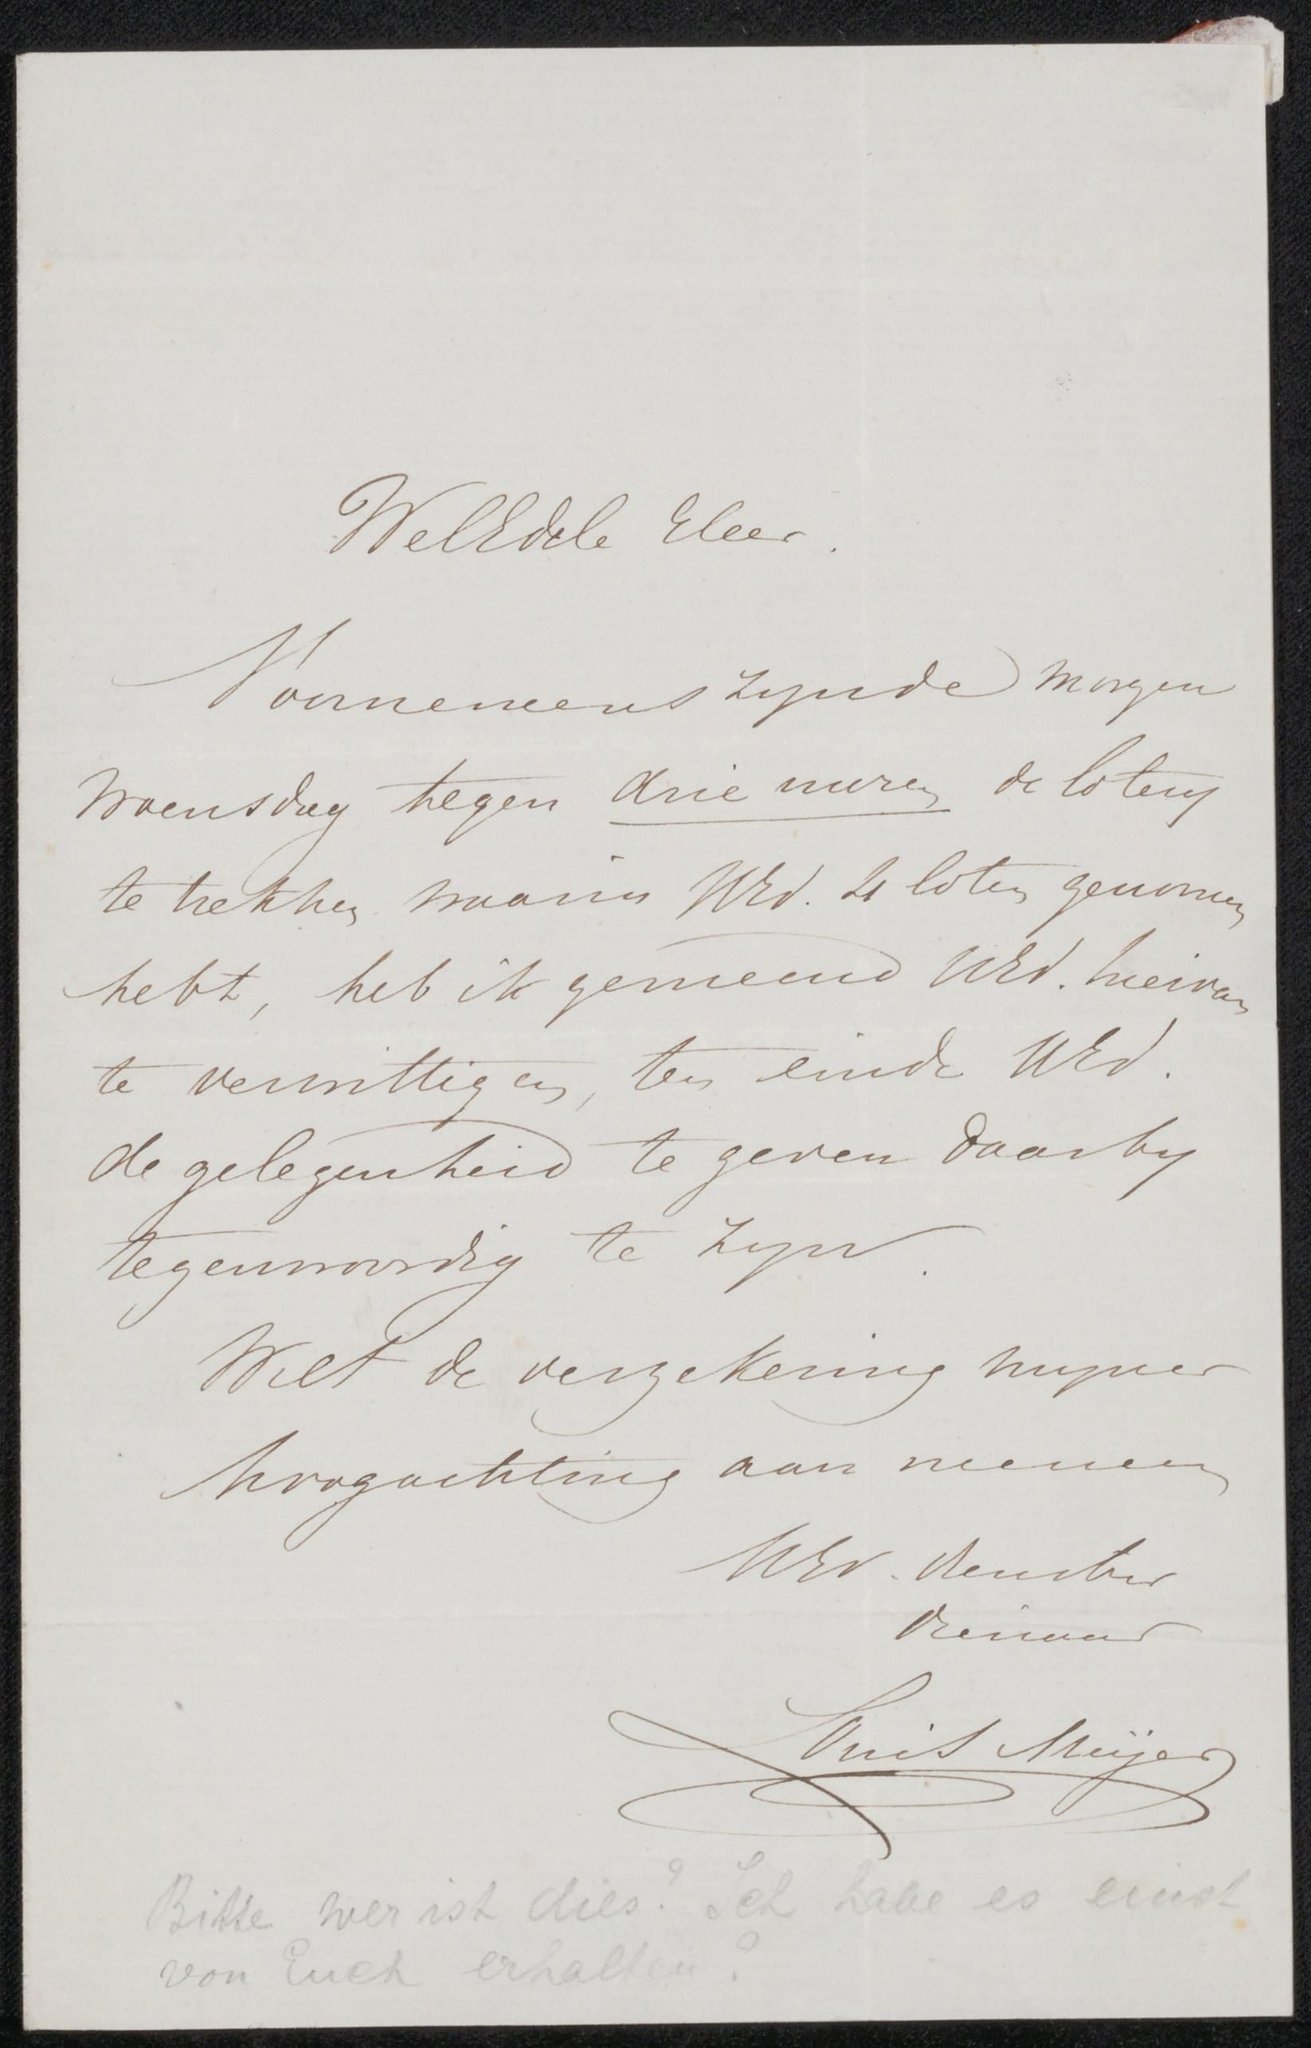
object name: letter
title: Brief aan de heer Van den Berg, notaris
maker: louis meijer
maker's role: draughtsman, painter, print maker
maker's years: 1809-1866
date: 1819-1866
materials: ink, paper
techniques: pen, writing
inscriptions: seal